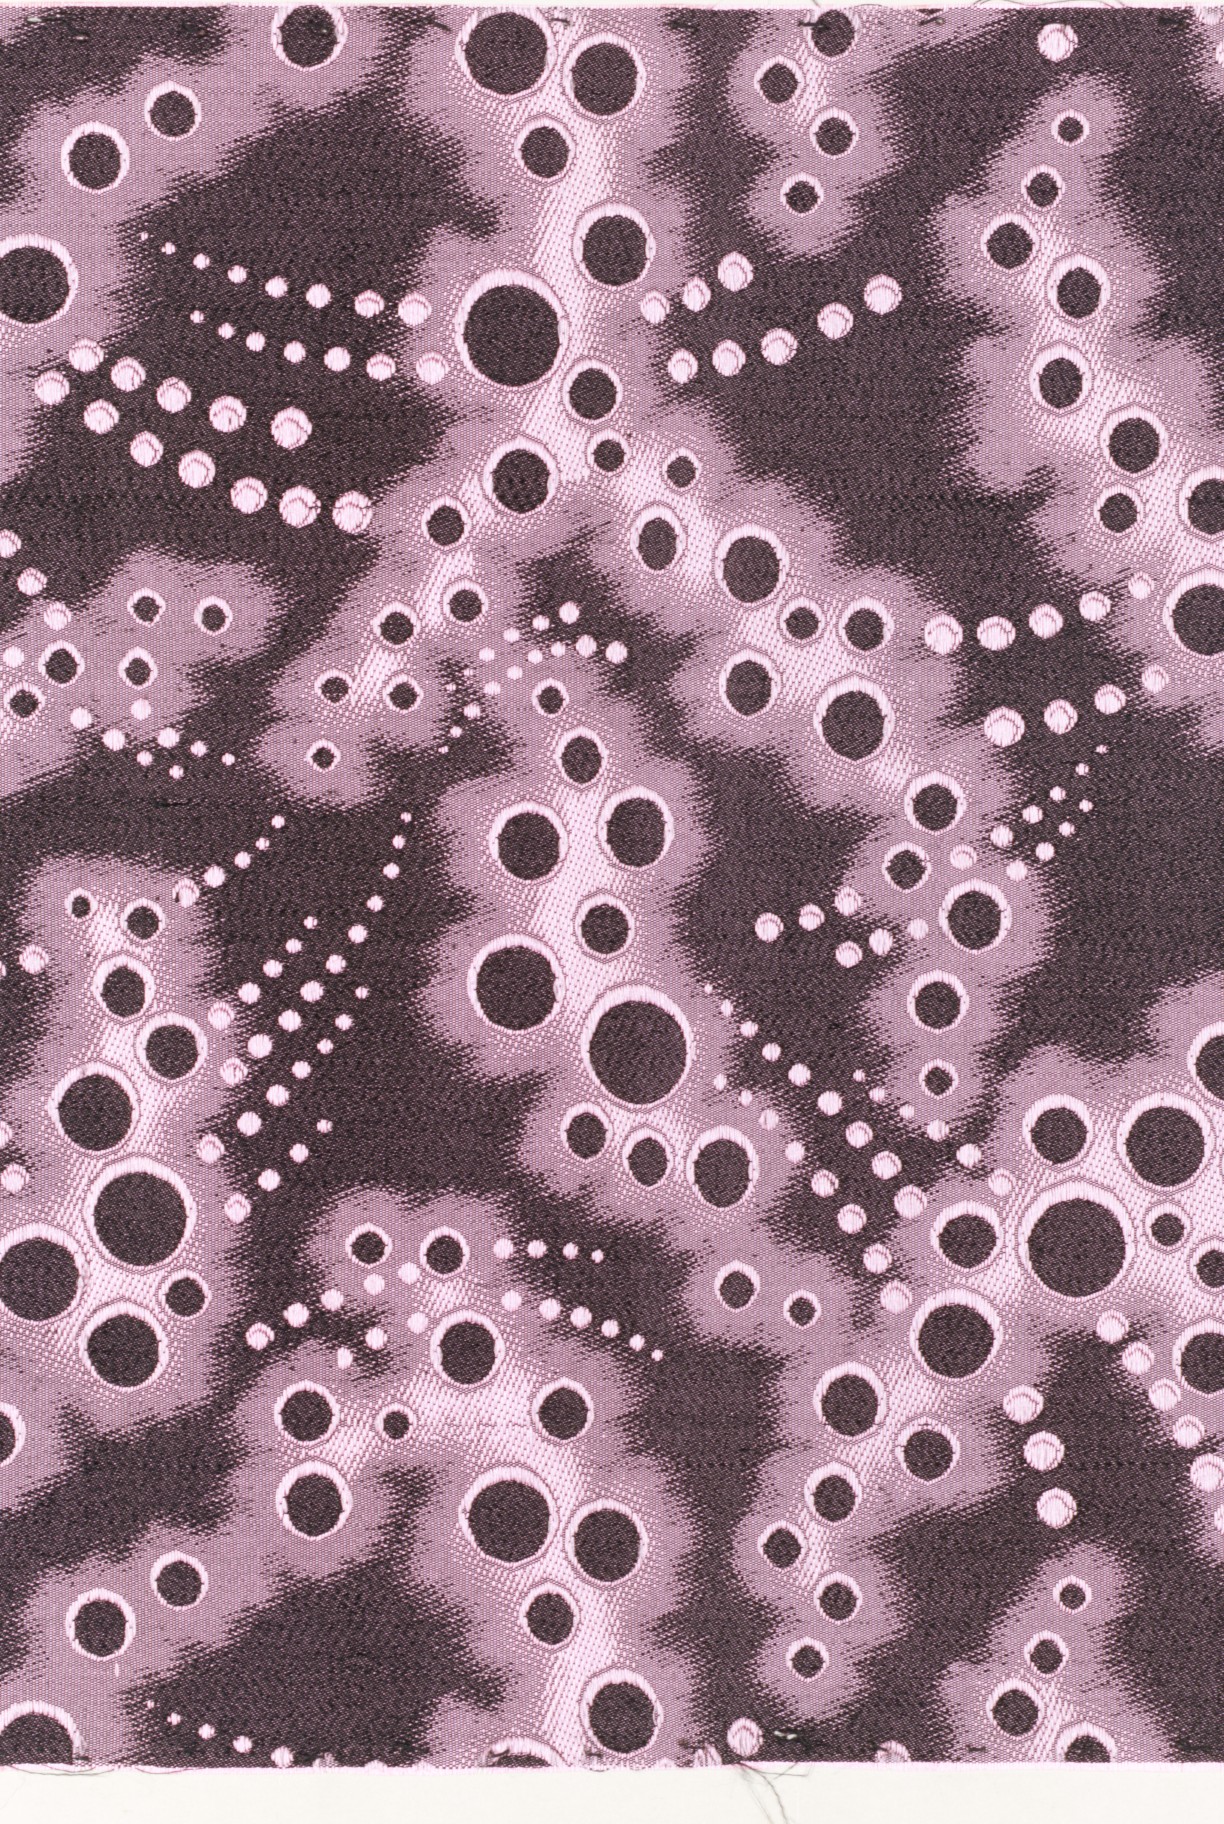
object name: textile sample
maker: Anonymous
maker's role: designer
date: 1900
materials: silk